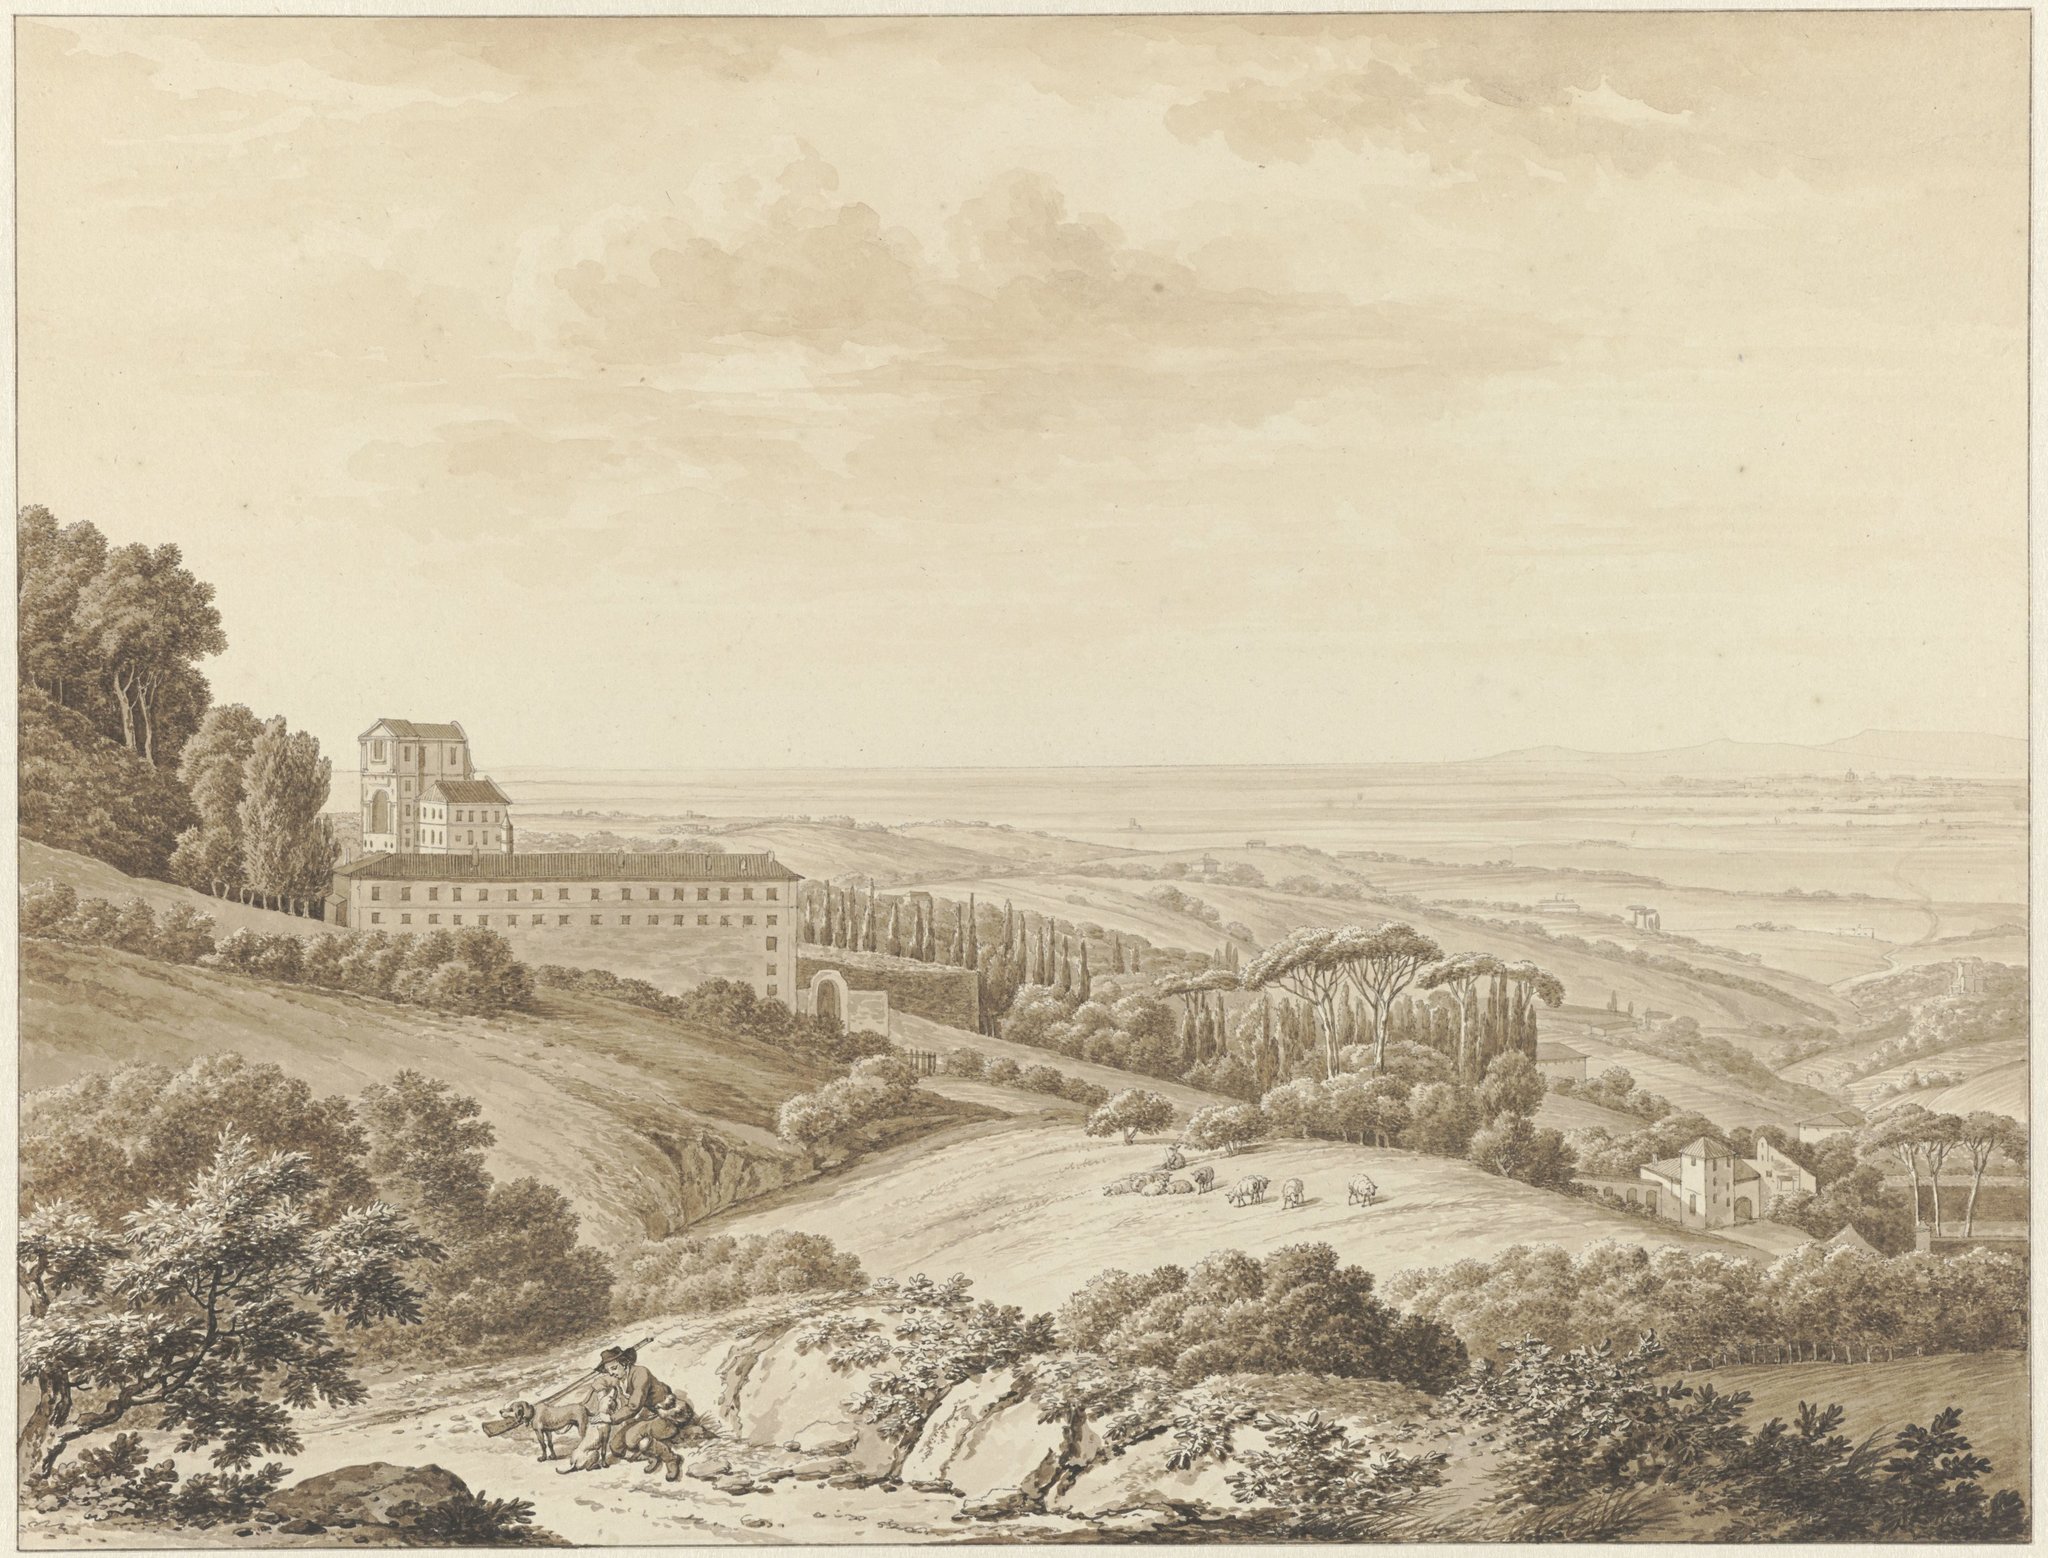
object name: drawing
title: The Villa Aldobrandini near Frascati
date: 1783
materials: graphite, ink, paper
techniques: brush, pen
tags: landscapes in the temperate zone, villa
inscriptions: date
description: Like most of his fellow artists, Dupré worked not only in the city of Rome, but regularly ventured into the countryside. Here he is in Frascati, a town southeast of Rome. At the left is the 16th-century Palazzo Aldobrandini, and with some effort the silhouette of Rome can be discerned in the distance at the right.